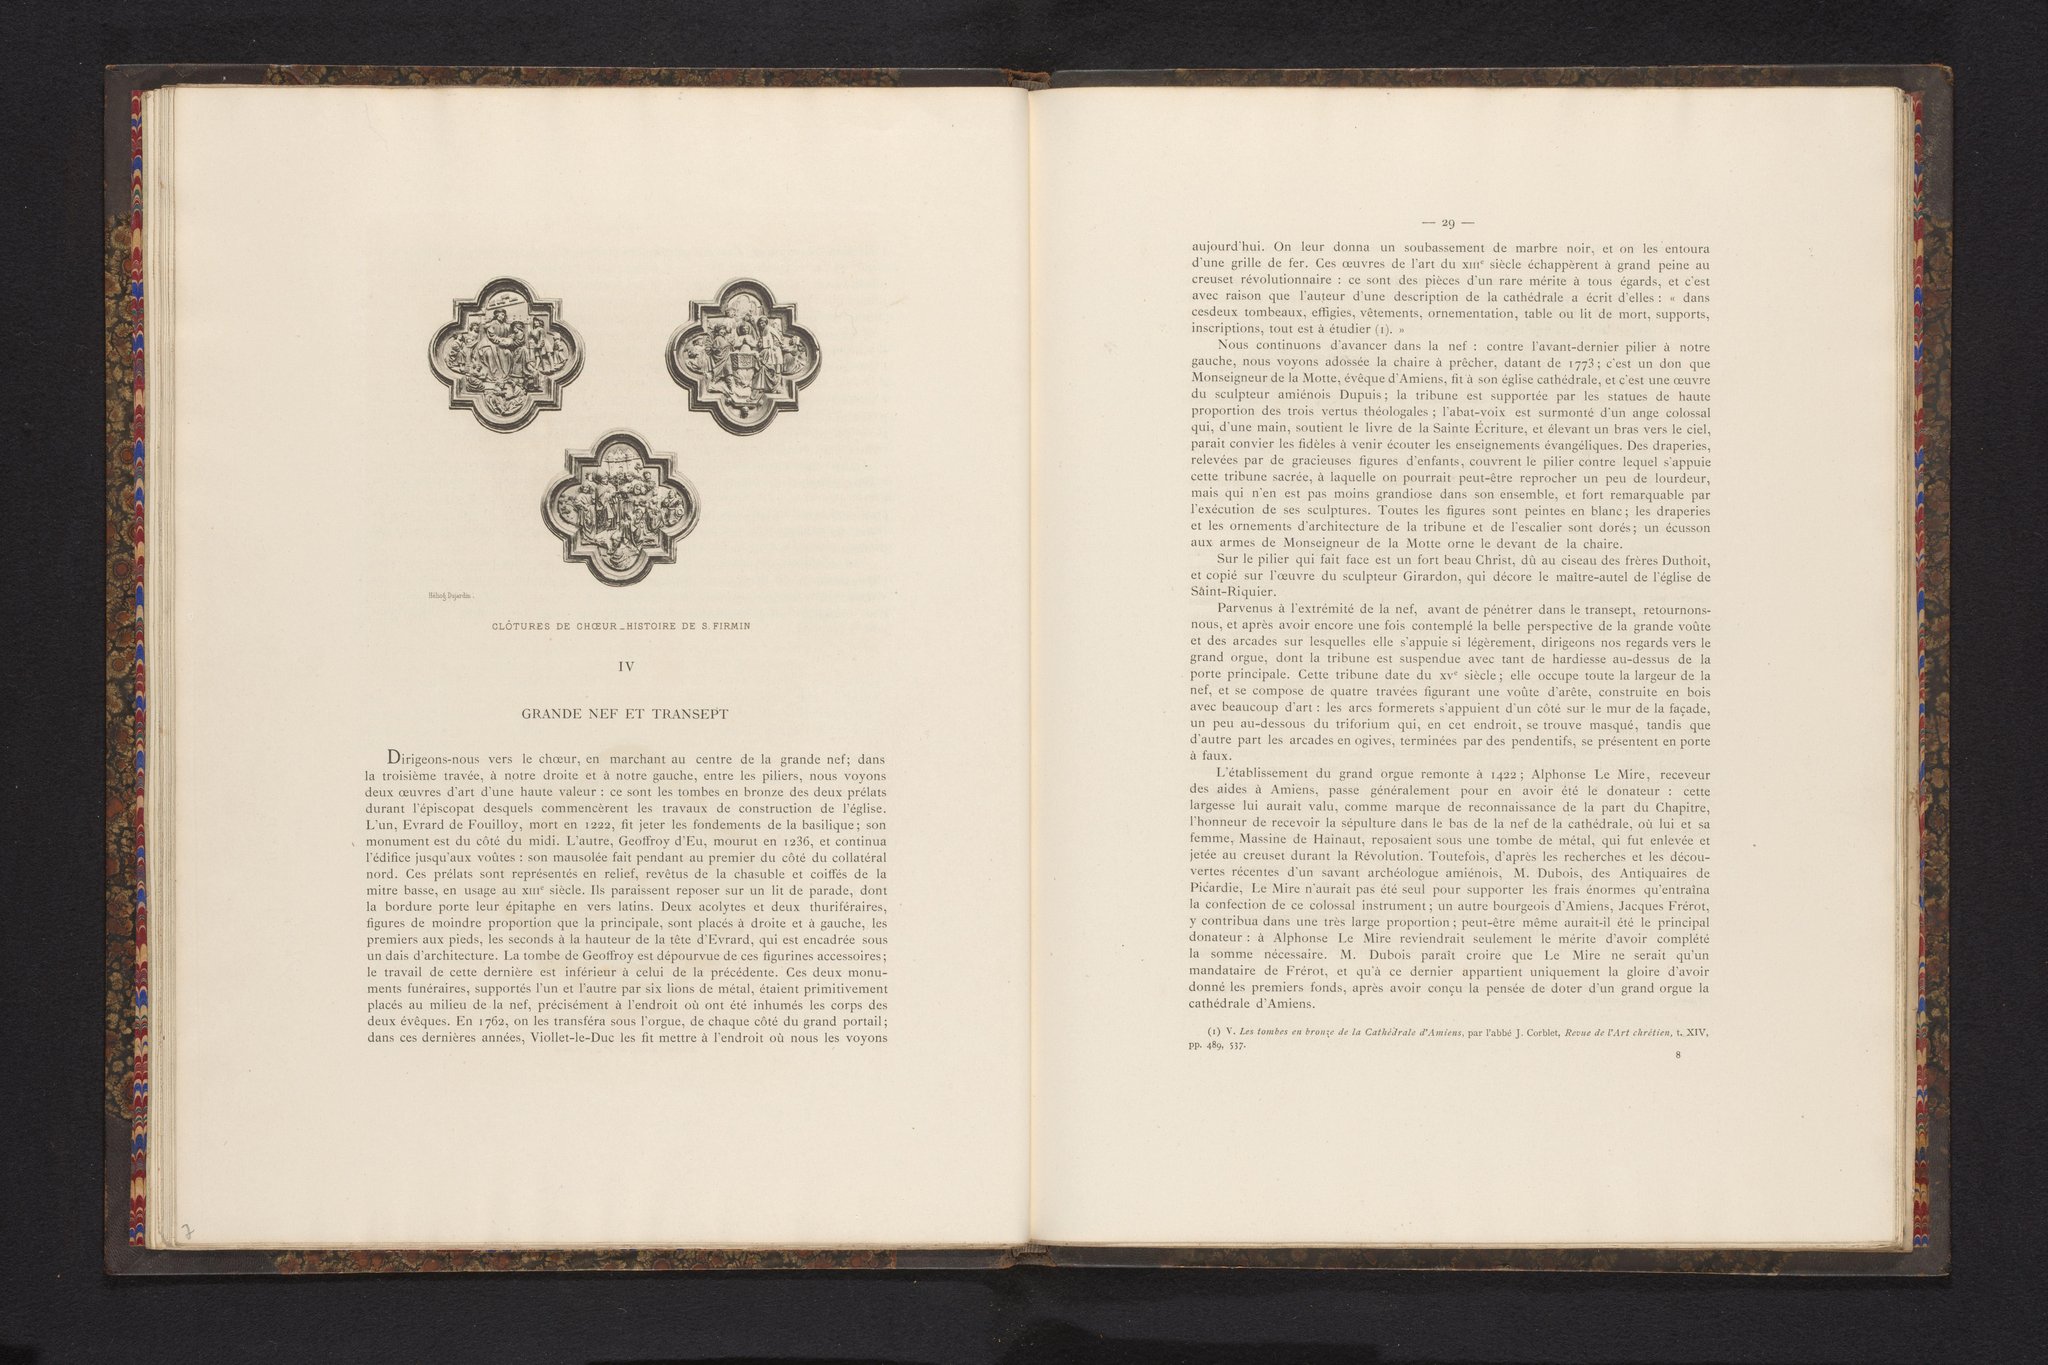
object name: page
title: Drie reliëfs over Firminus van Amiens in de Notre-Dame van Amiens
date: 1888-1893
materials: paper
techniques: photograph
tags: female saints, sculpture (+ relief ~ sculpture), notre-dame d'amiens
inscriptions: inscription: ‘Clôtures de choeur histoire de S. Firmin’